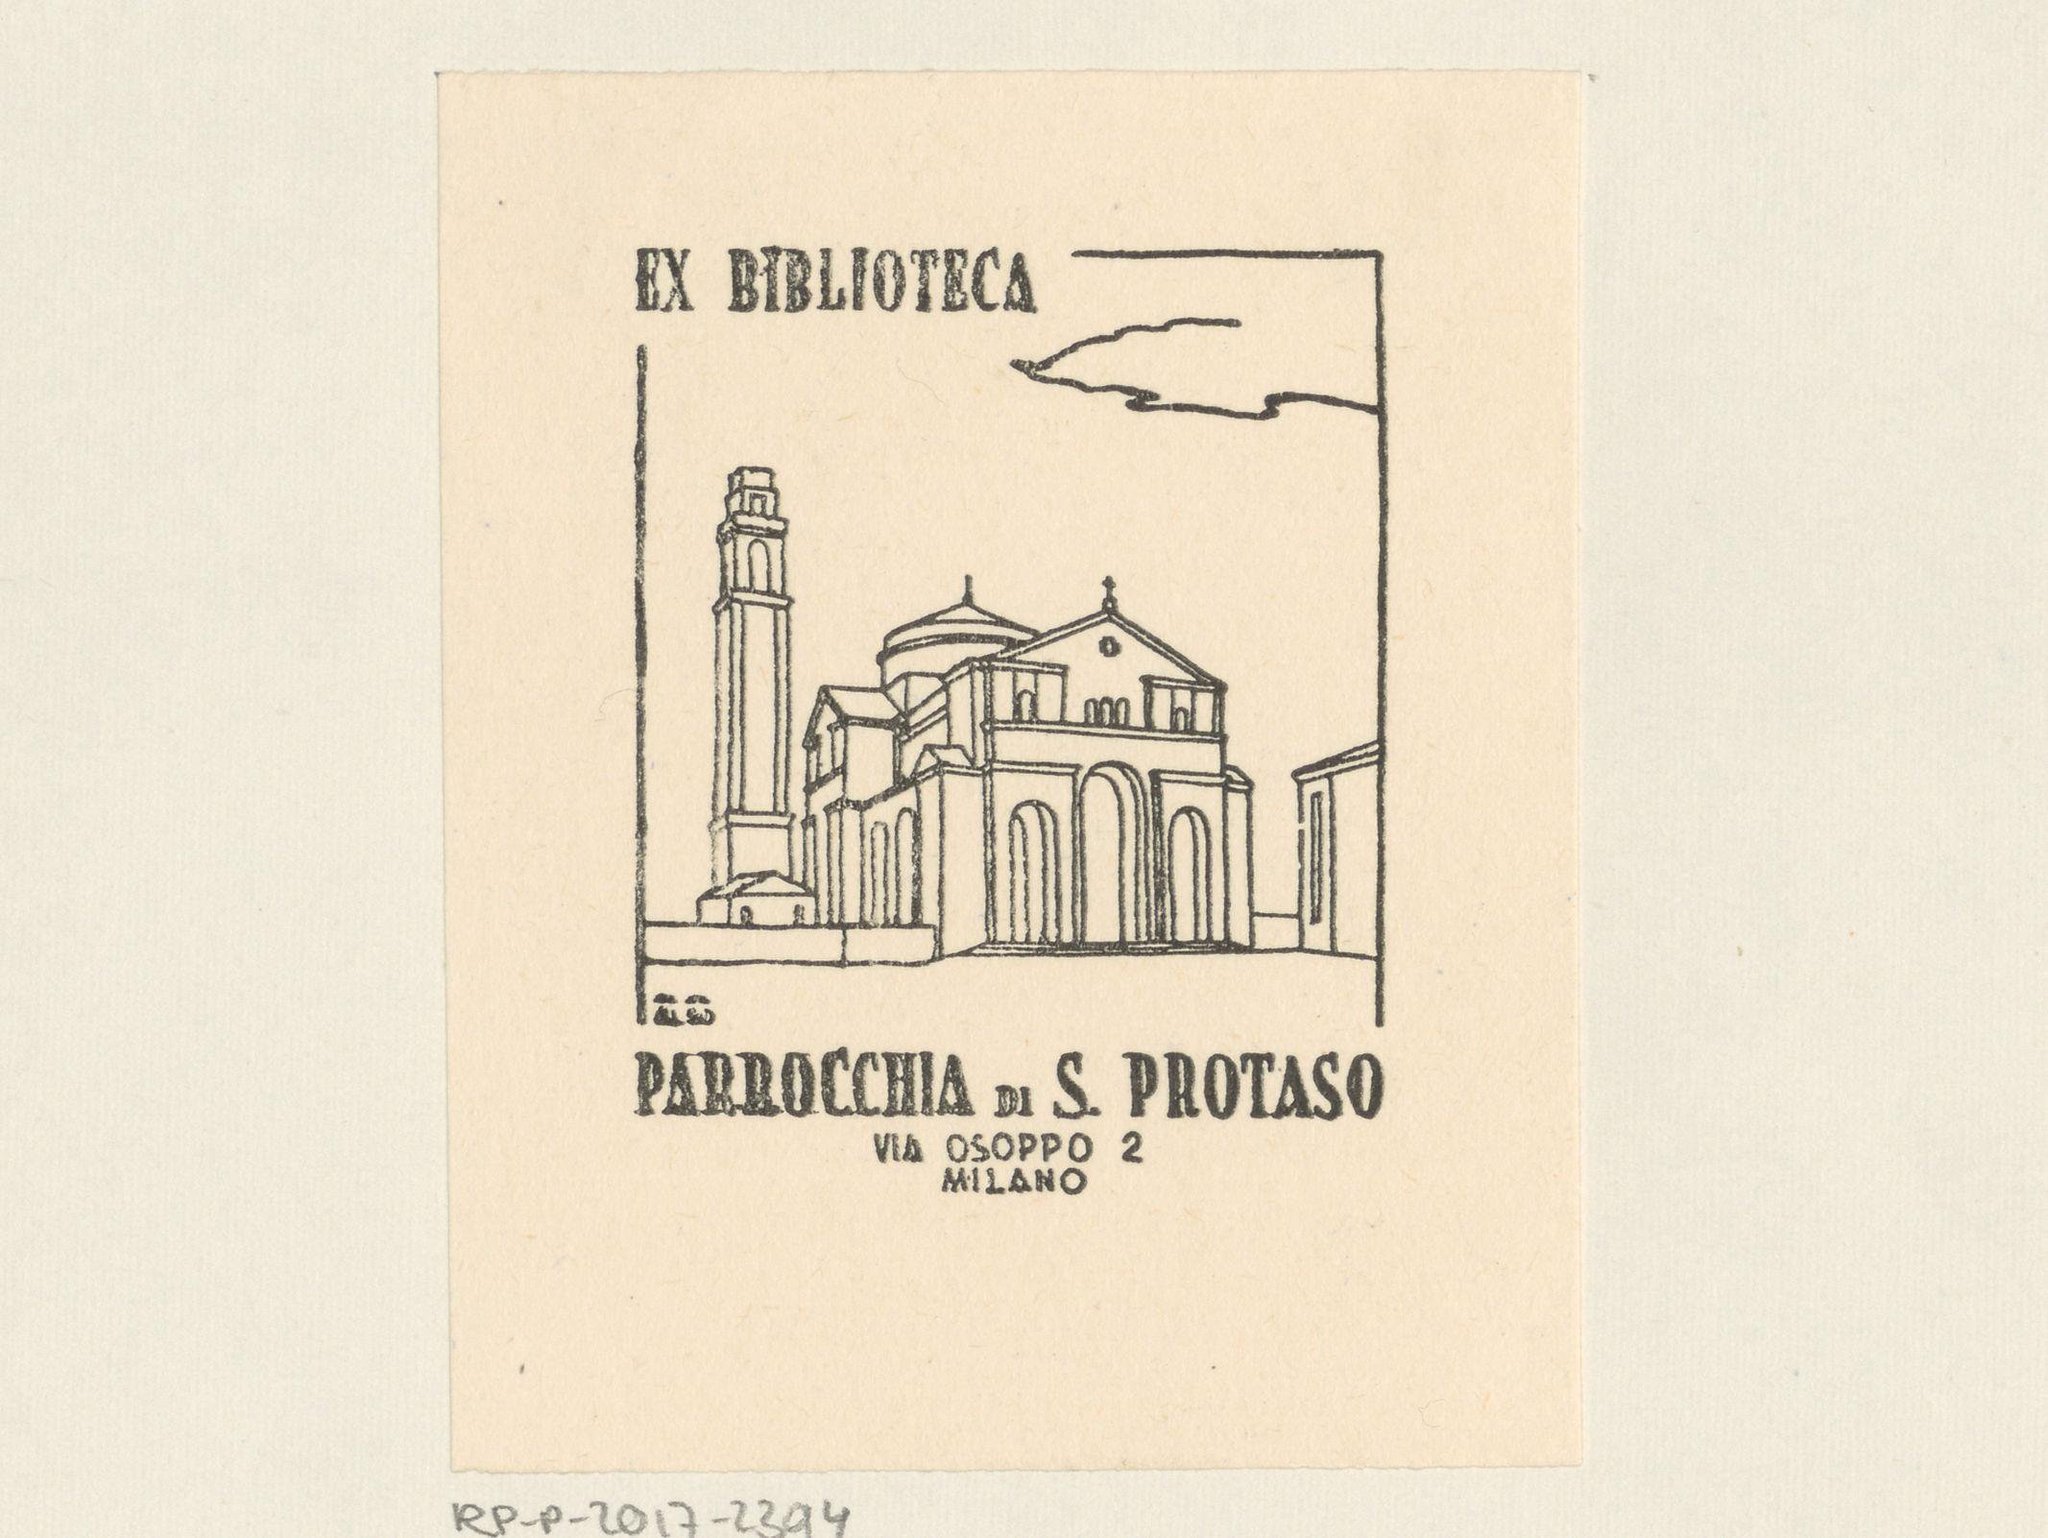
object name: bookplate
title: Ex libris van de Parrocchia di S. Protaso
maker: Anonymous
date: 1900-1999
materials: paper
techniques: printing block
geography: milan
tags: church (exterior)